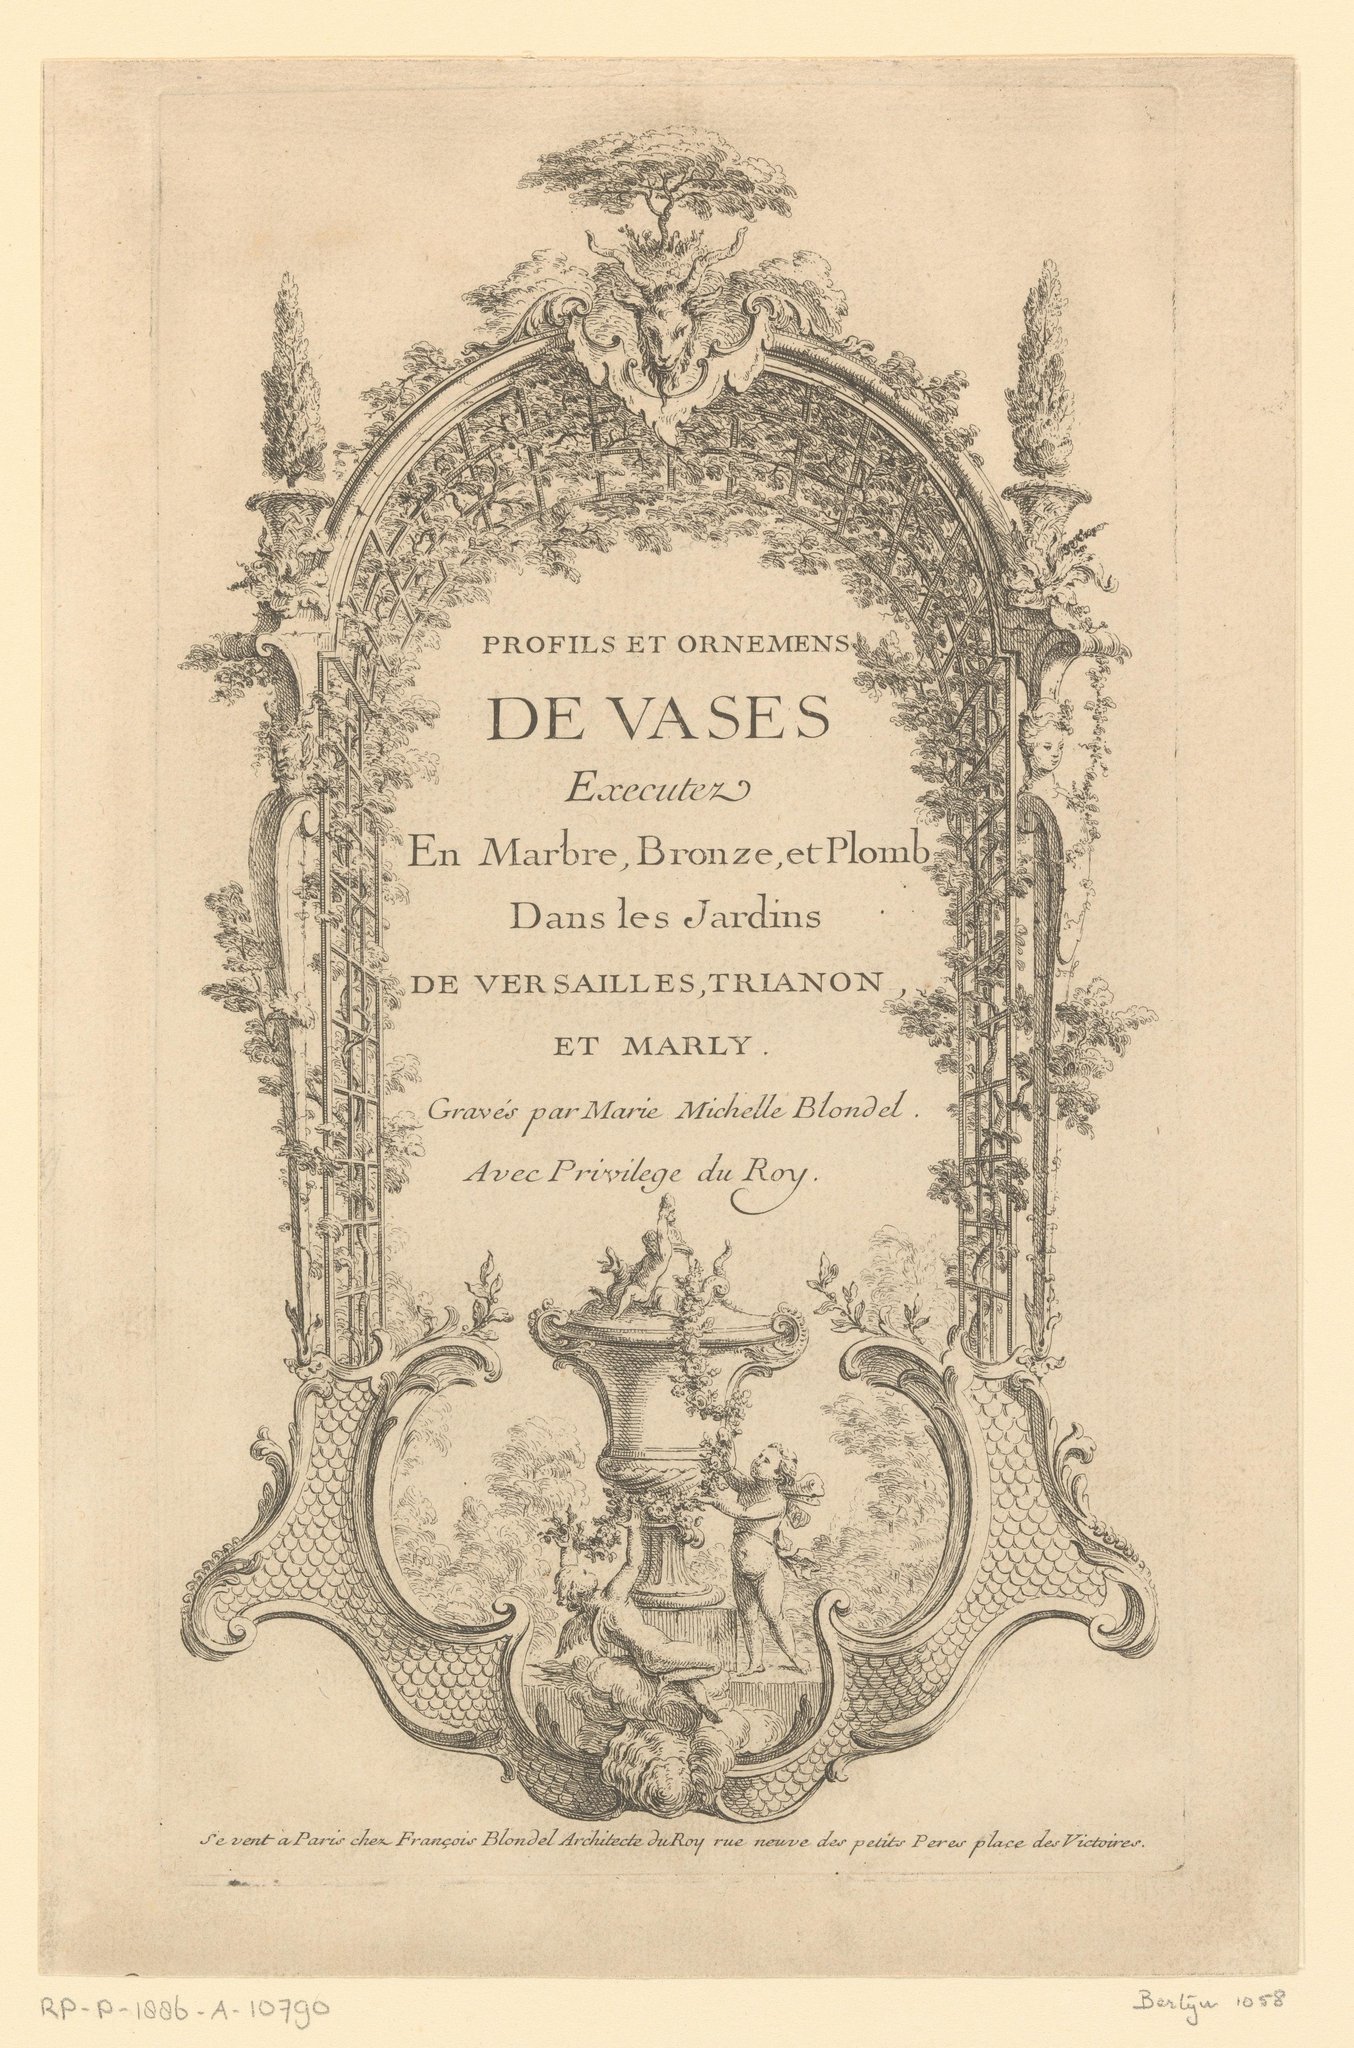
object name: titelprent, frontispice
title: Profils et ornemens de vases (...)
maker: marie michelle blondel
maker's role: print maker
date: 1723-1774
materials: paper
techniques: etching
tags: vase ~ ornament, cupids: 'amores', 'amoretti', 'putti'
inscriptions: collector's mark: Lugt 2228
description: Onder een rozenboog met bokkenkop en bustes staan twee putti met een guirlande bij een siervaas.